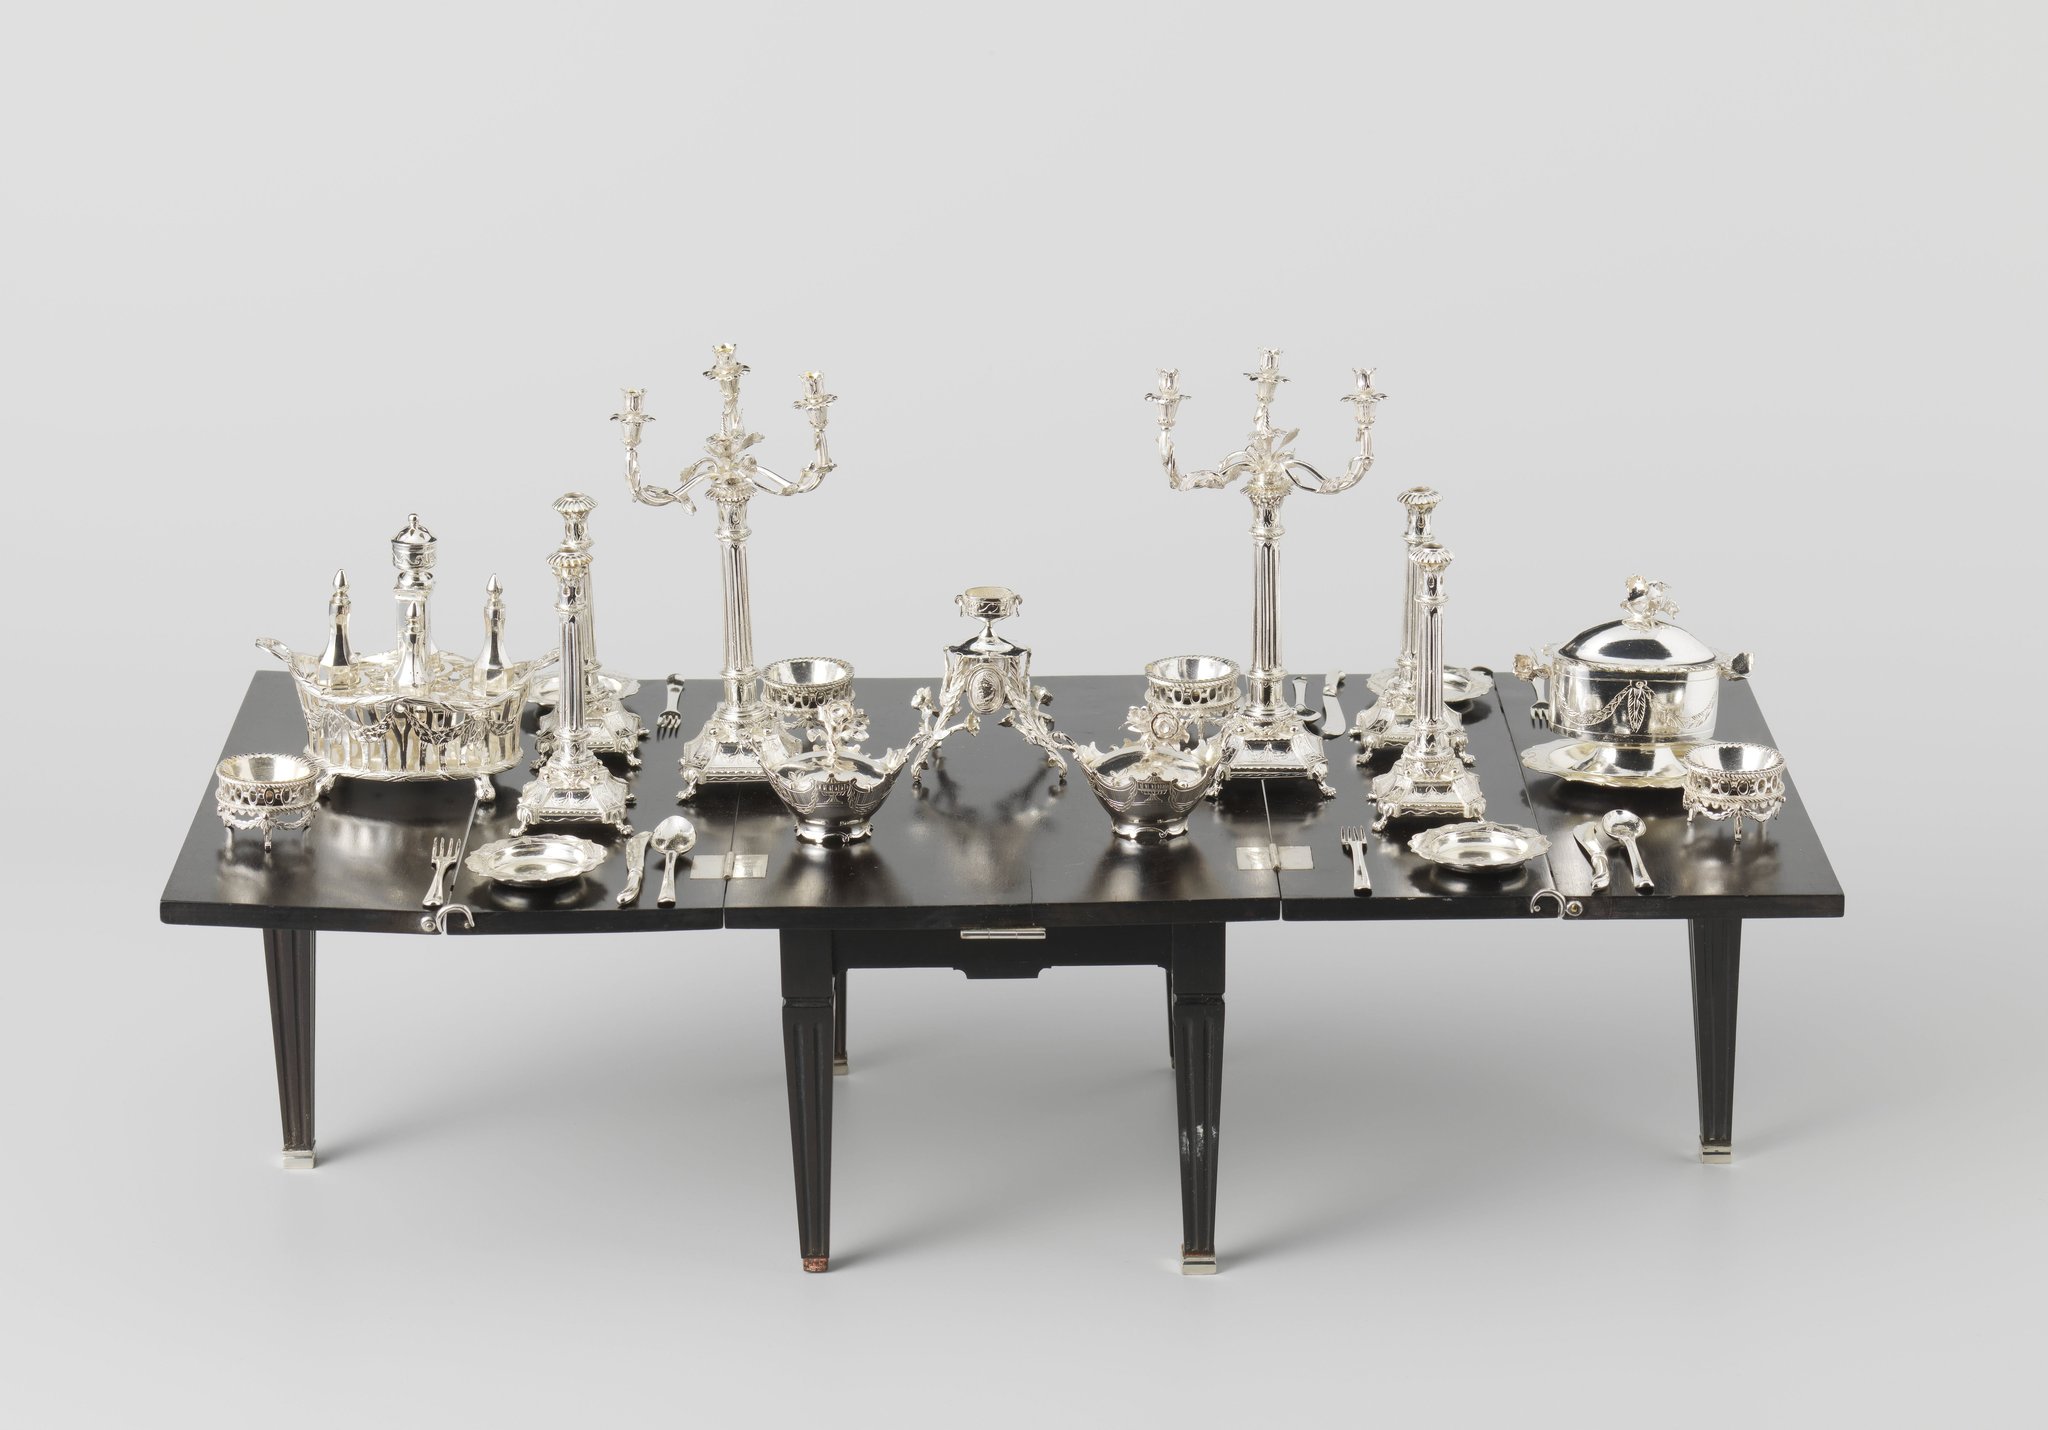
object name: miniature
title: Kandelaar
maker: Anonymous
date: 1782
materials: silver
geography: amsterdam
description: Kandelaar op vierkante voet. De voet heeft afgeschuinde hoeken en staat op vier klauwpoten. De stam heeft de vorm van een gecanneleerde zuil met een kapiteel. De kandelaar is gemerkt: stk.= Amsterdam, jrl.= X (1782) en een onbekend meesterteken.